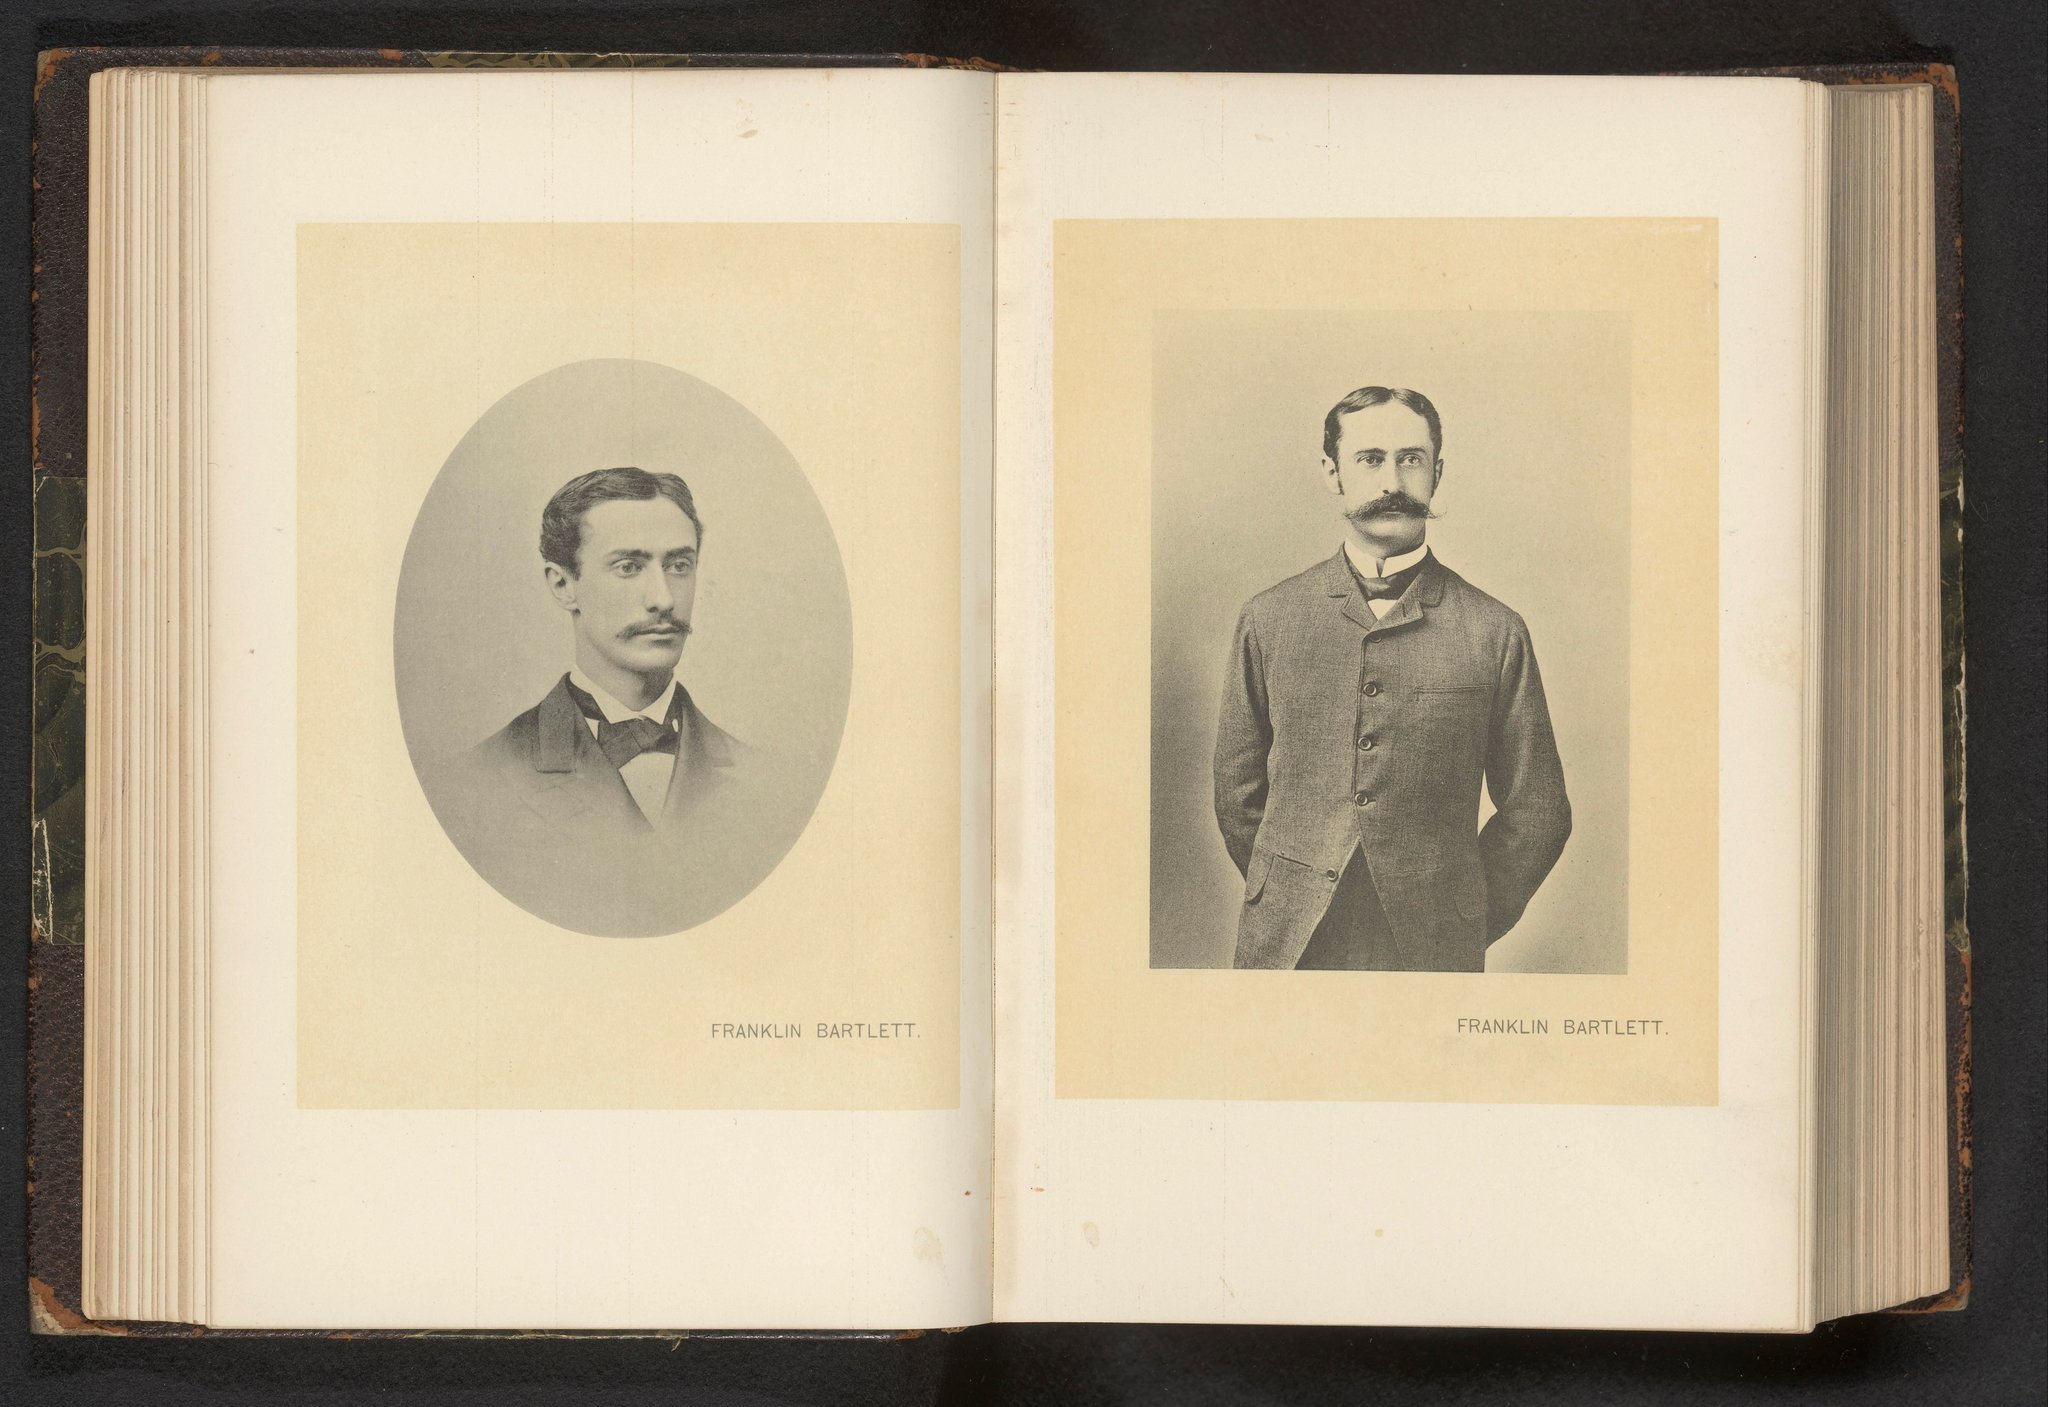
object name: page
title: Franklin Bartlett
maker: Anonymous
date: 1889-1894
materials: paper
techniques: photoaquatint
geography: boston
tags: politician, politician, e.g. party leader